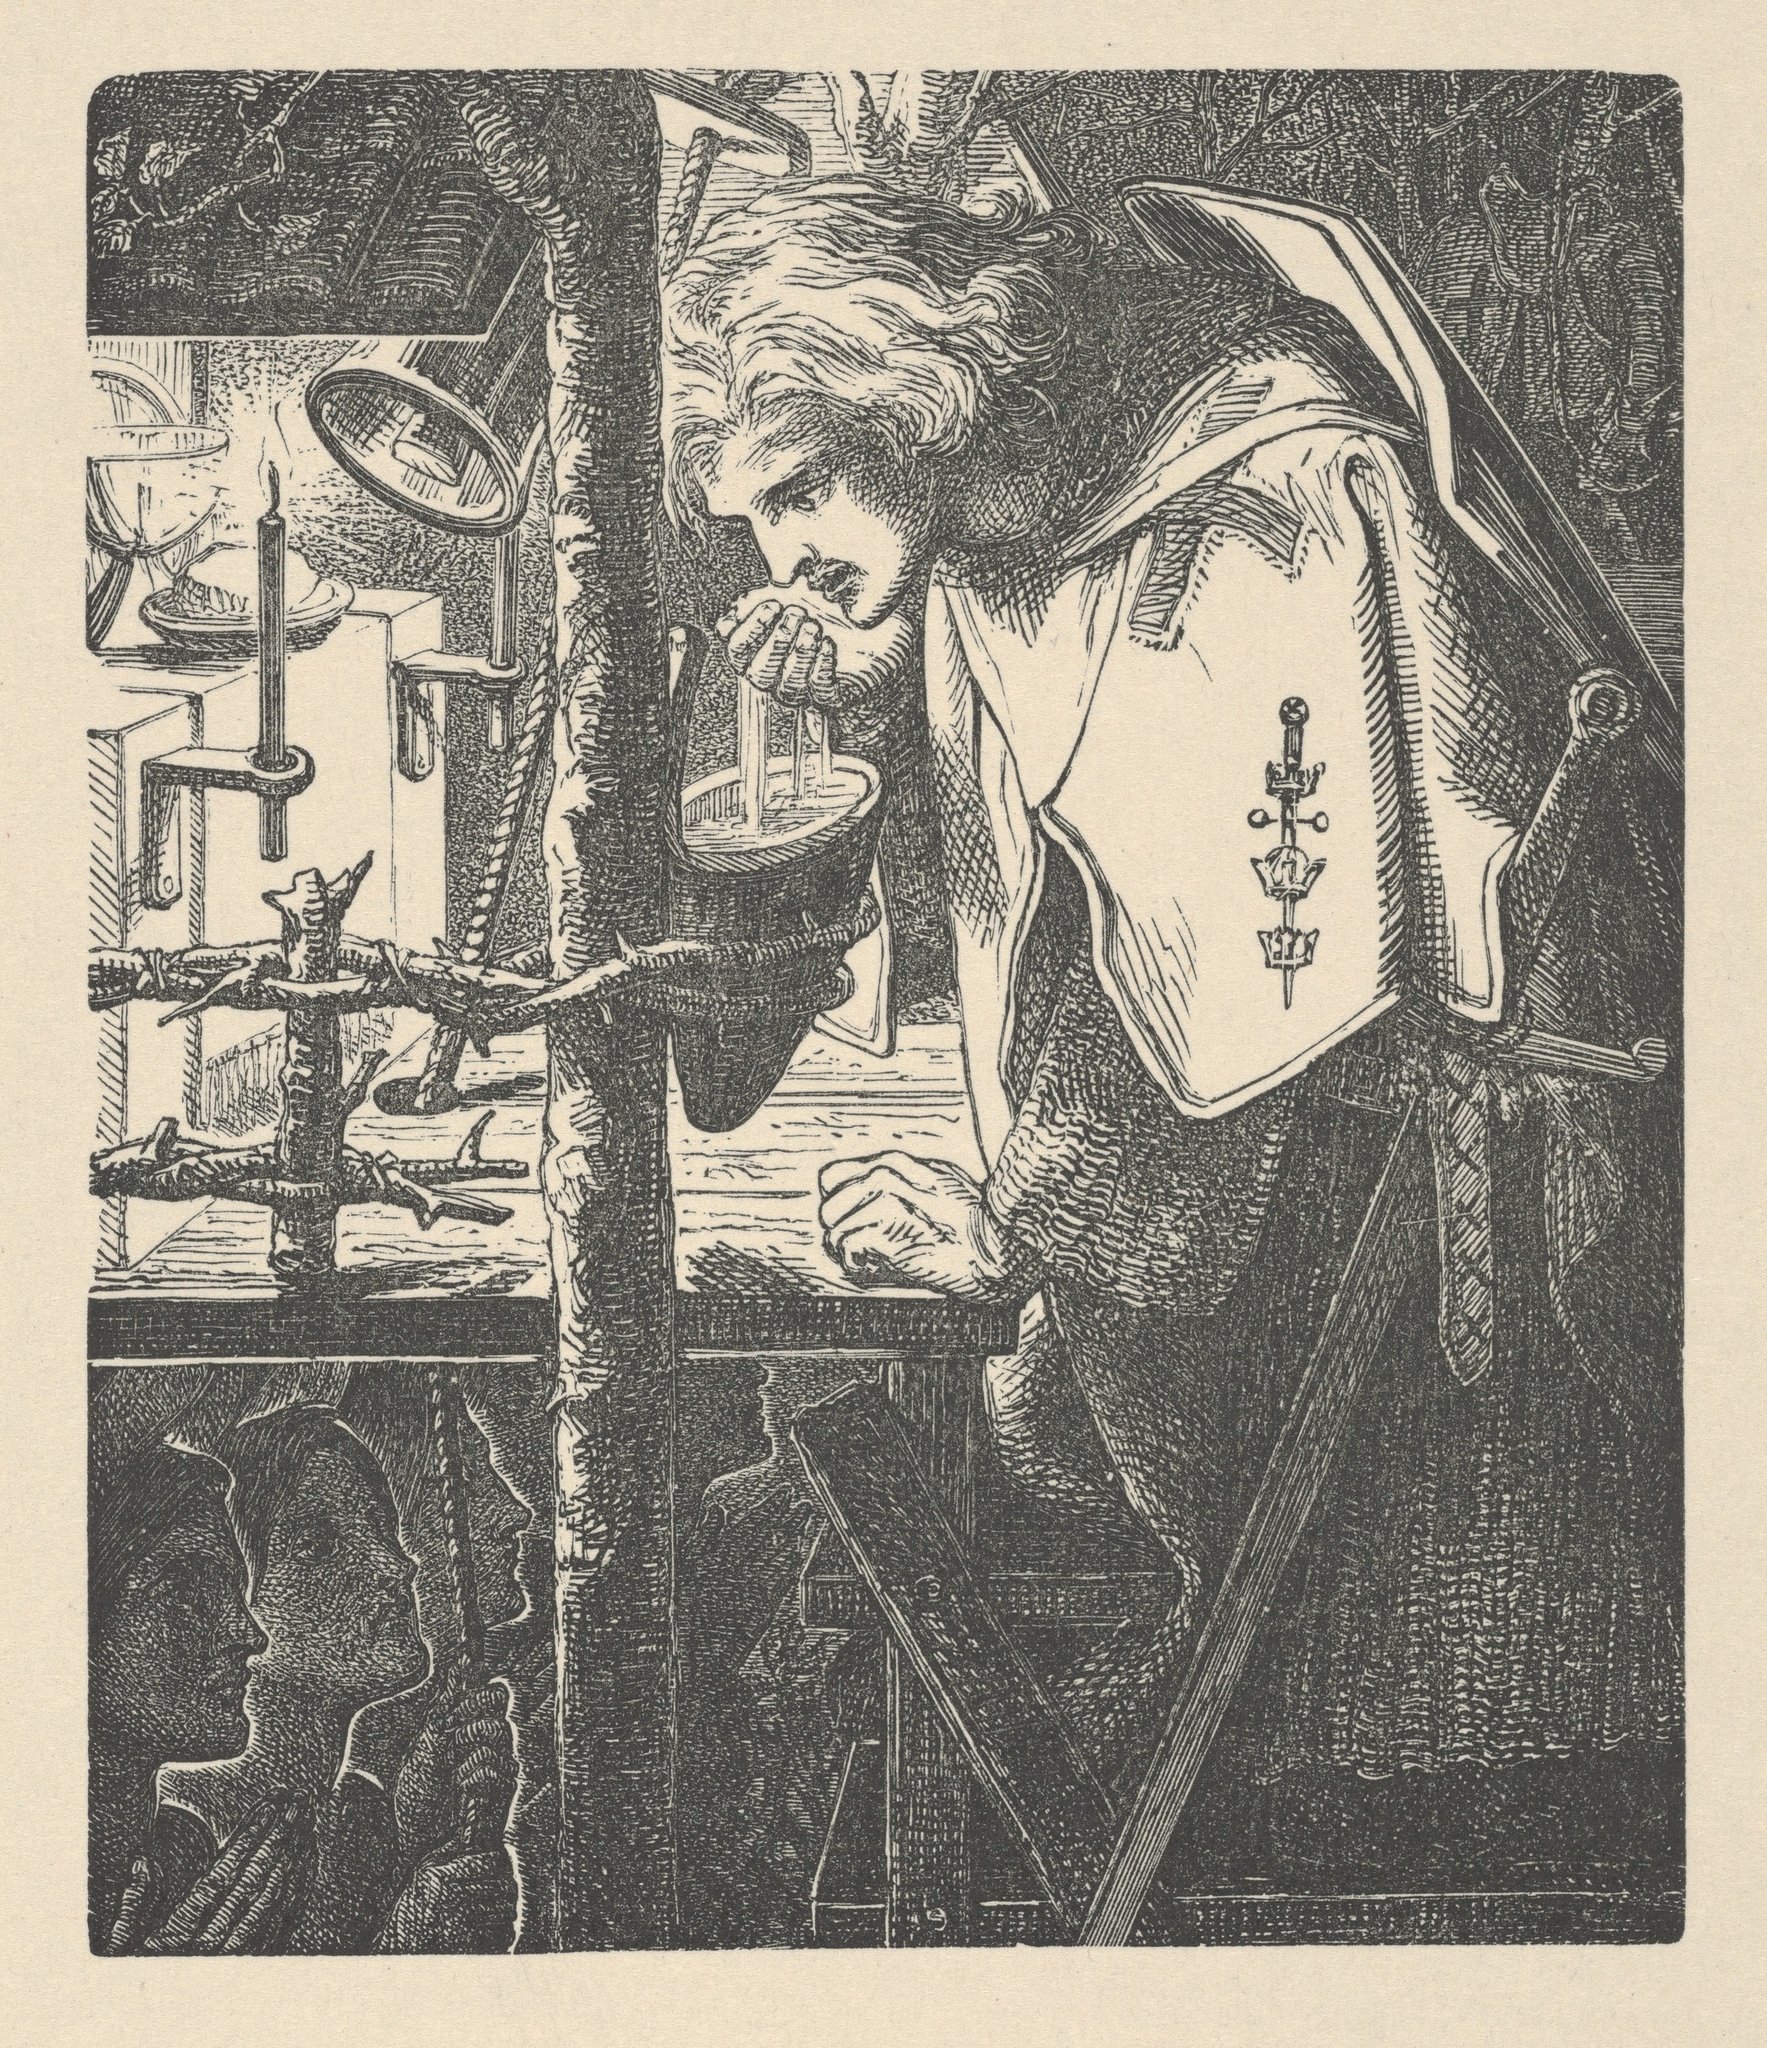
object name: print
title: Sir Galahad (from Tennyson's Poems, New York, 1903)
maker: dante gabriel rossetti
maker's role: artist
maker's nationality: british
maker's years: 1828-1882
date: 1857-1903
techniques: engraving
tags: swords,men,knights,candles